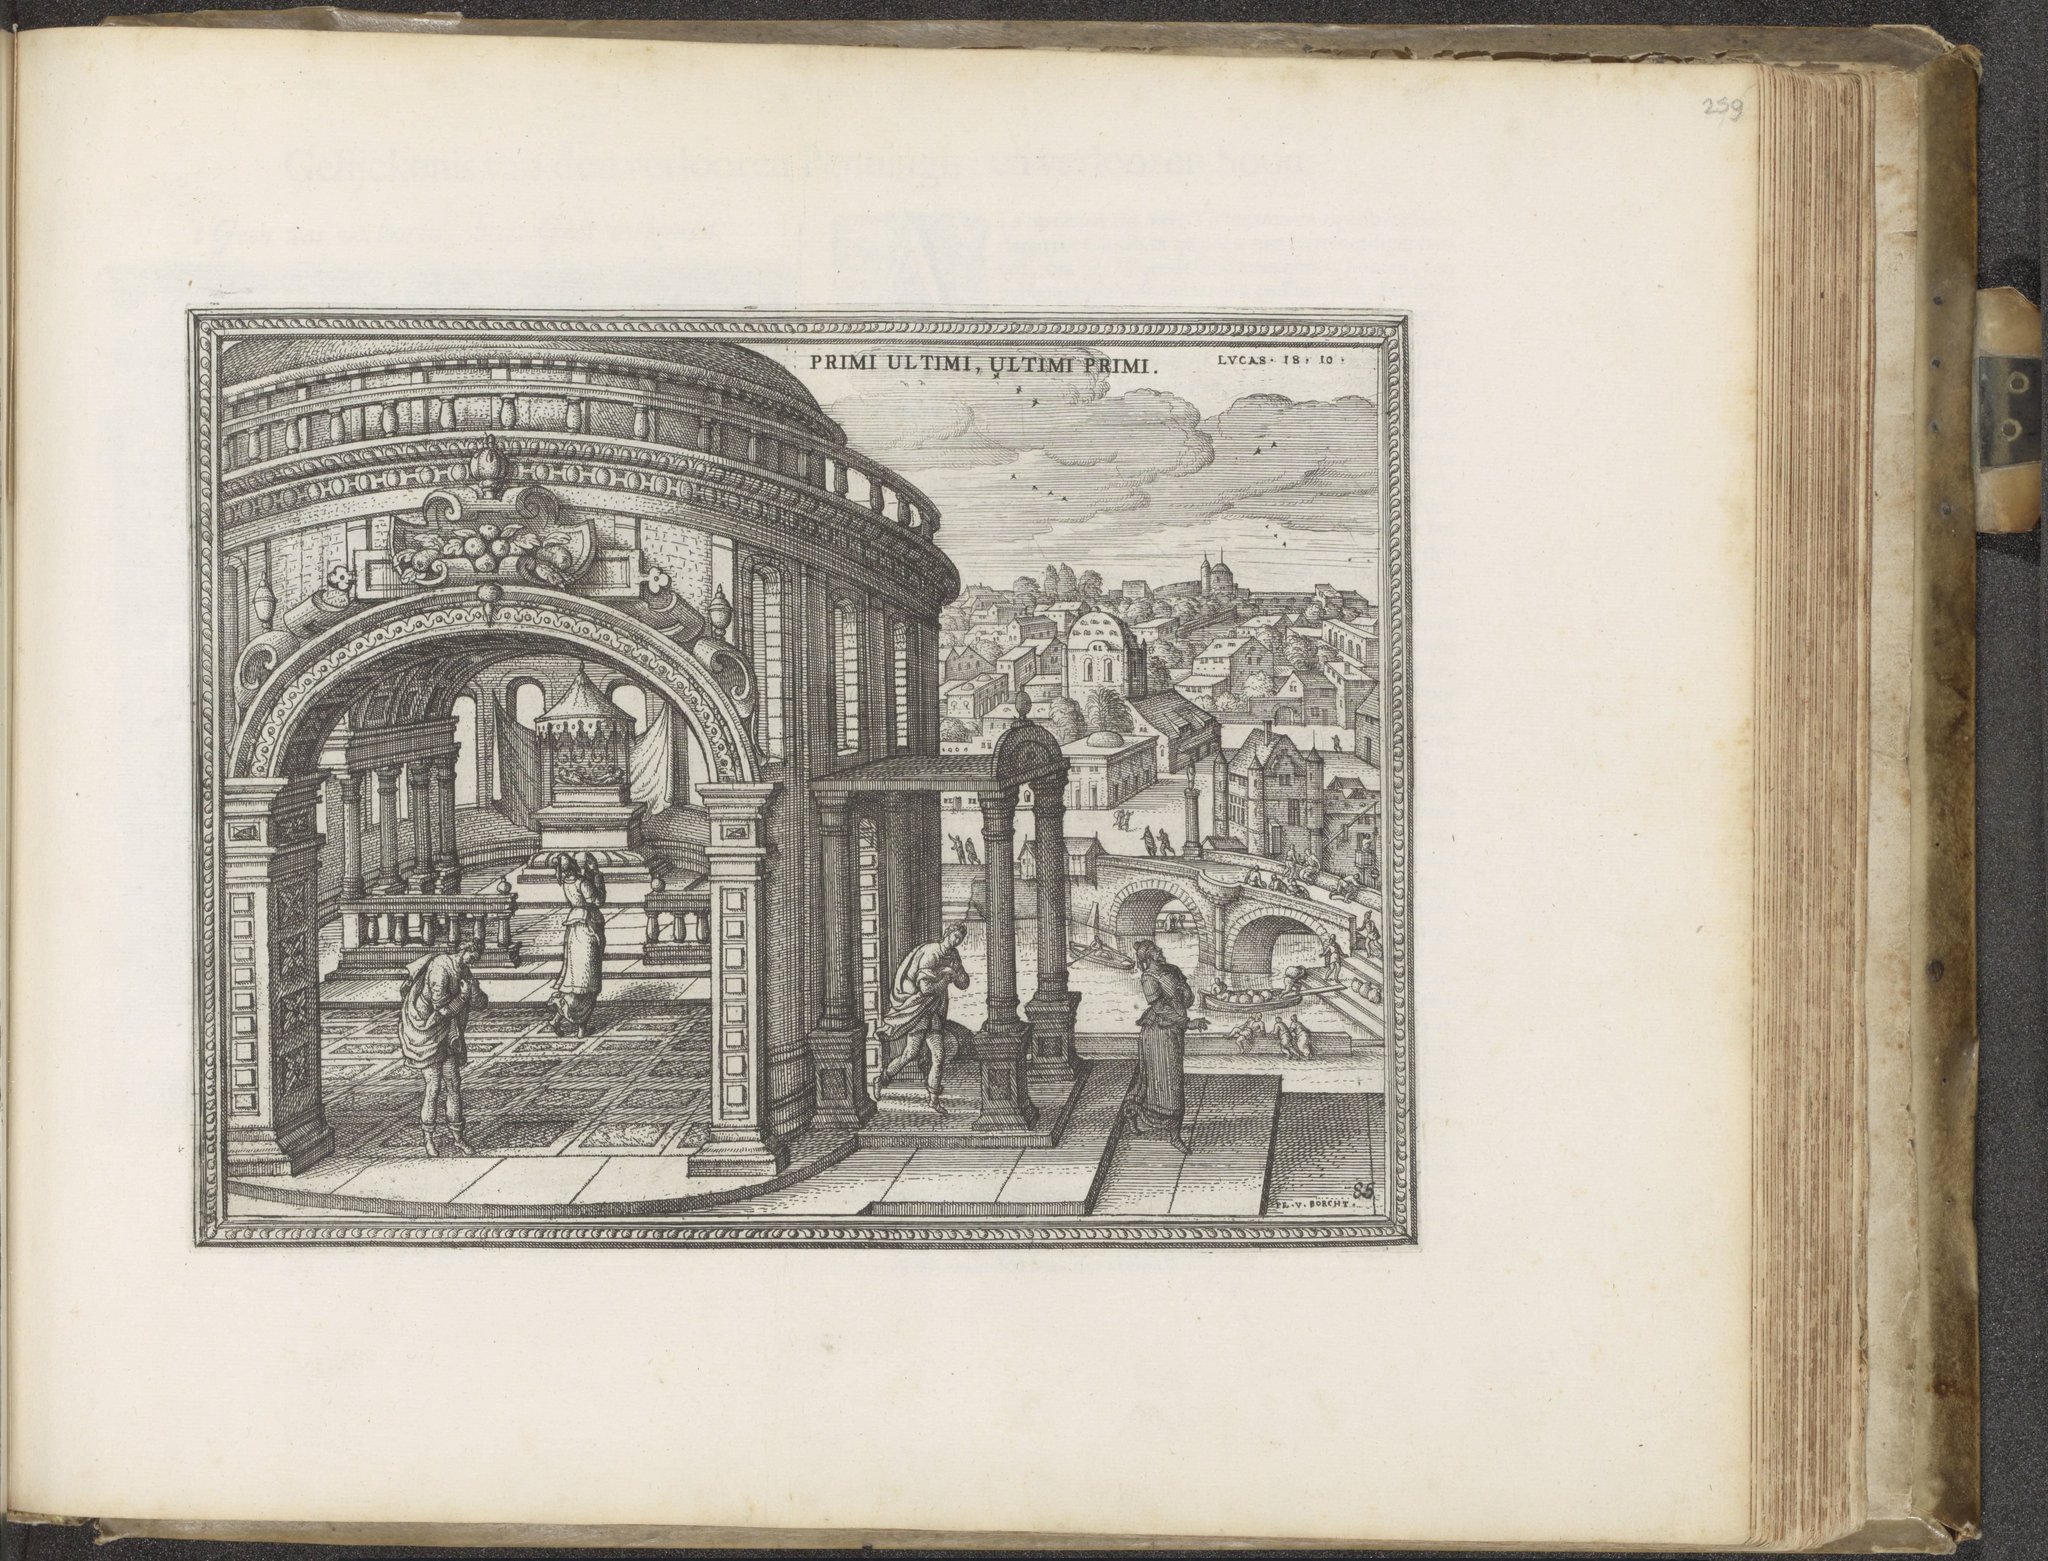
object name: album leaf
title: Gelijkenis van de farizeeër en de tollenaar in de tempel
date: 1582-1593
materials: paper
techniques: etching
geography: amsterdam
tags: the praying pharisee and the repentant publican in the temple (luke 18:10-14)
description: Gelijkenis van de farizeeër en de tollenaar die naar de tempel gingen om te bidden. De farizeeër stond daar bij het altaar en verlaat de tempel rechtop. De tollenaar bleef op afstand staan en durfde zijn blik niet naar de hemel te richten. Hij verlaat de tempel gebogen (Luc. 18:10). De prent maakt deel uit van een album.